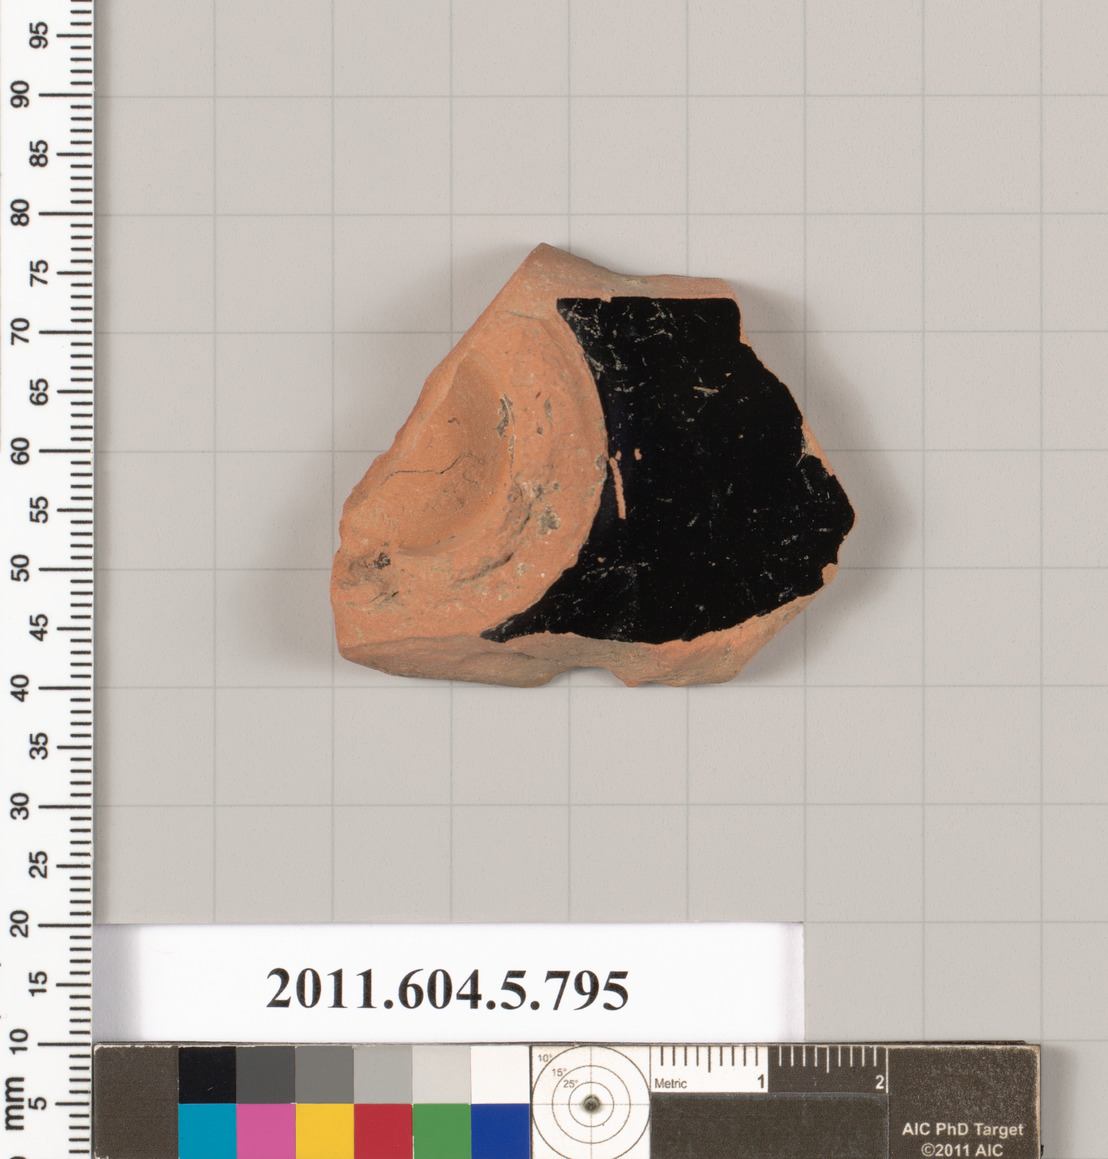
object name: kylix fragment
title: Terracotta fragment of a kylix (drinking cup)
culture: greek, attic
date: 600-401 BCE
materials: terracotta